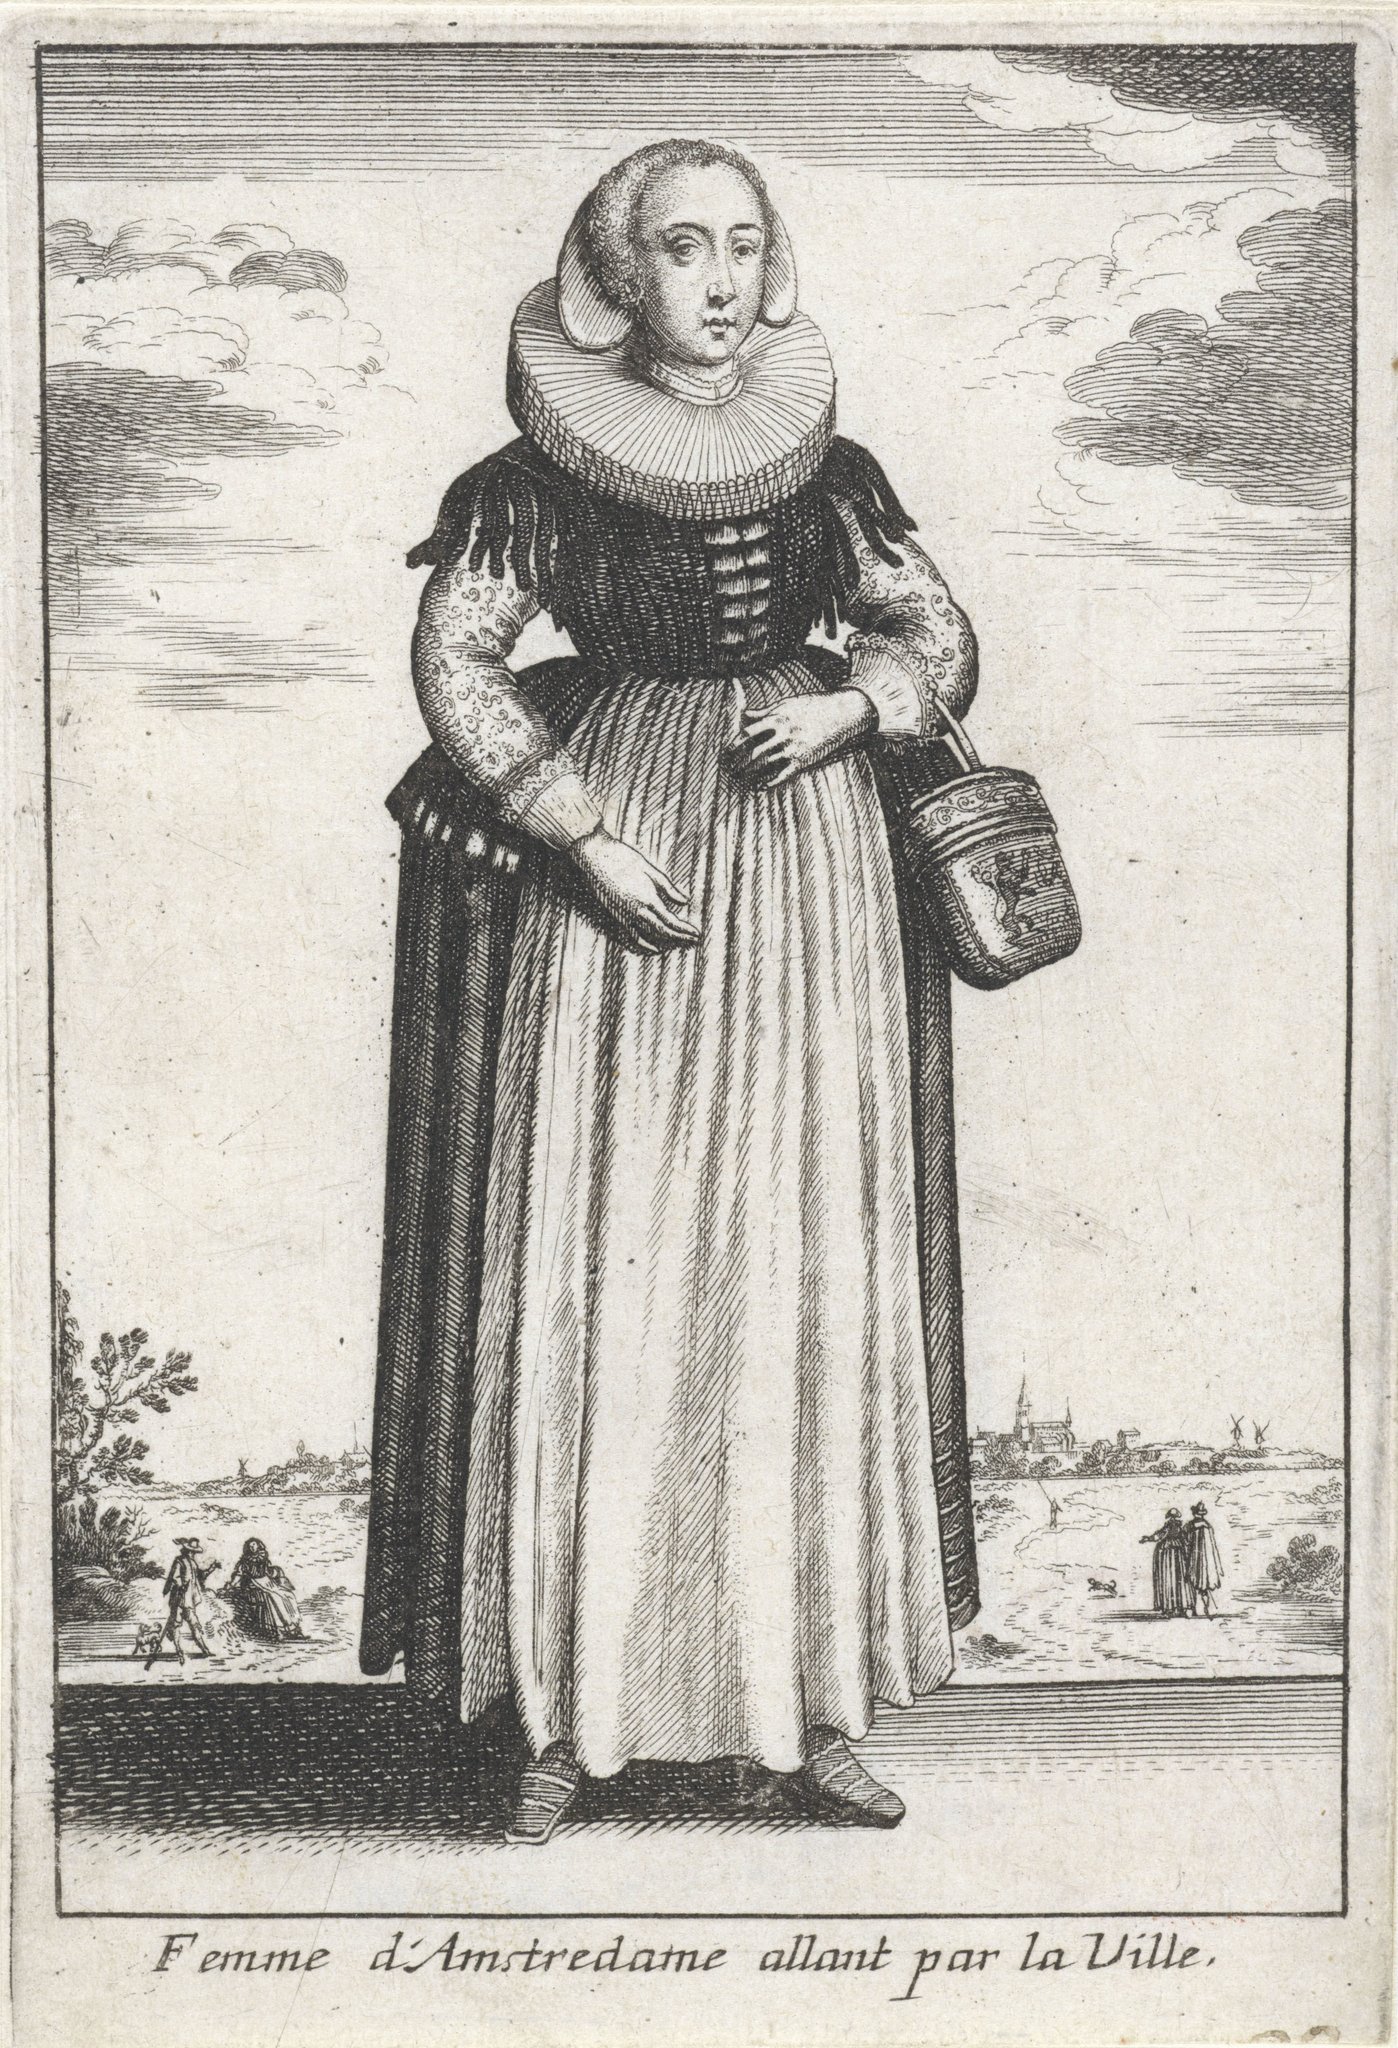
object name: costume print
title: Livre Curieux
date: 1662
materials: paper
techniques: etching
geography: paris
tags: europeans (dutch) (+ women), clothing for the upper part of the body (bodice) (+ fur used for clothes), head-gear: cap (+ women's clothes), shoes, sandals (+ women's clothes), neck-gear ~ clothing (with name) (+ women's clothes), carrying something in basket, bag, rucksack, etc., container made of plant material other than wood: basket, skirt (+ women's clothes), sleeves: cuffs (+ women's clothes), apron (+ women's clothes), sleeves (+ women's clothes), clothing for the upper part of the body (with name) (+ women's clothes), amsterdam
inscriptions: collector's mark: Lugt 240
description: Amsterdamse vrouw die naar de stad gaat. Op het naar achteren gekamde kroezend haar op het achterhoofd een mutsje met 'vleugels' die aan weerszijden van het gezicht uitstaan. Een grote, dikke plooikraag met in de hals het boord van het hemd zichtbaar. Gerimpeld mouwloos jak afgezet met bont en rondom de schoudergaten voorzien van losse, afhangende stroken stof of linten. Lange mouwen van stof met strooimotief en teruggeslagen, geplooide manchetten afgezet met kant. Ruime, enkellange rok versierd met horizontale banden boven de zoom. Lang wit schort, straks rond de taille gebonden zodat het jak een getailleerde vorm krijgt. Versierde schoenen met hogere hak. Aan de linkerarm een versierde mand met deksel en hengsel ('bennetje') waarop twee elkaar toegewende leeuwen die een wapenschild op houden. Kopie naar "Mercatoris Hollandici Vxor / Merchants wife of Holland" .